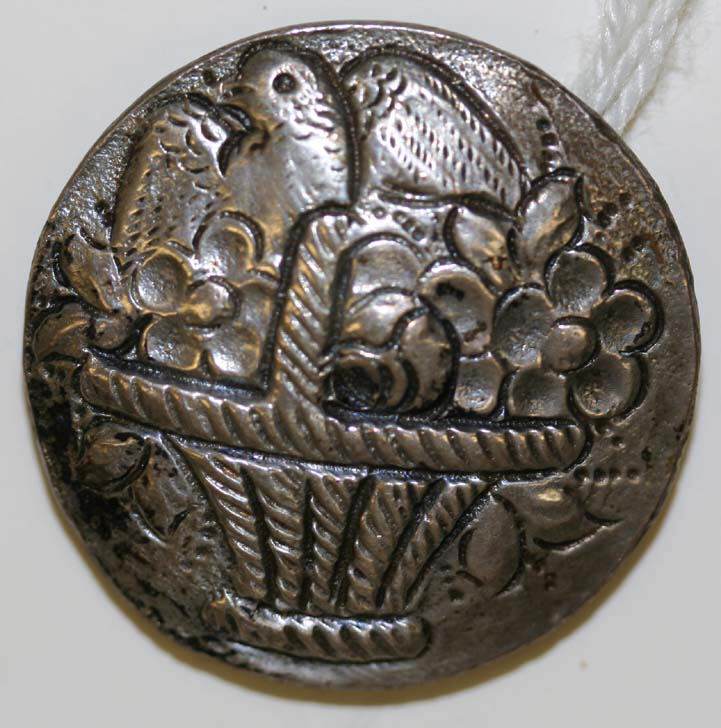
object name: button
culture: french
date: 1701-1800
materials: metal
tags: birds